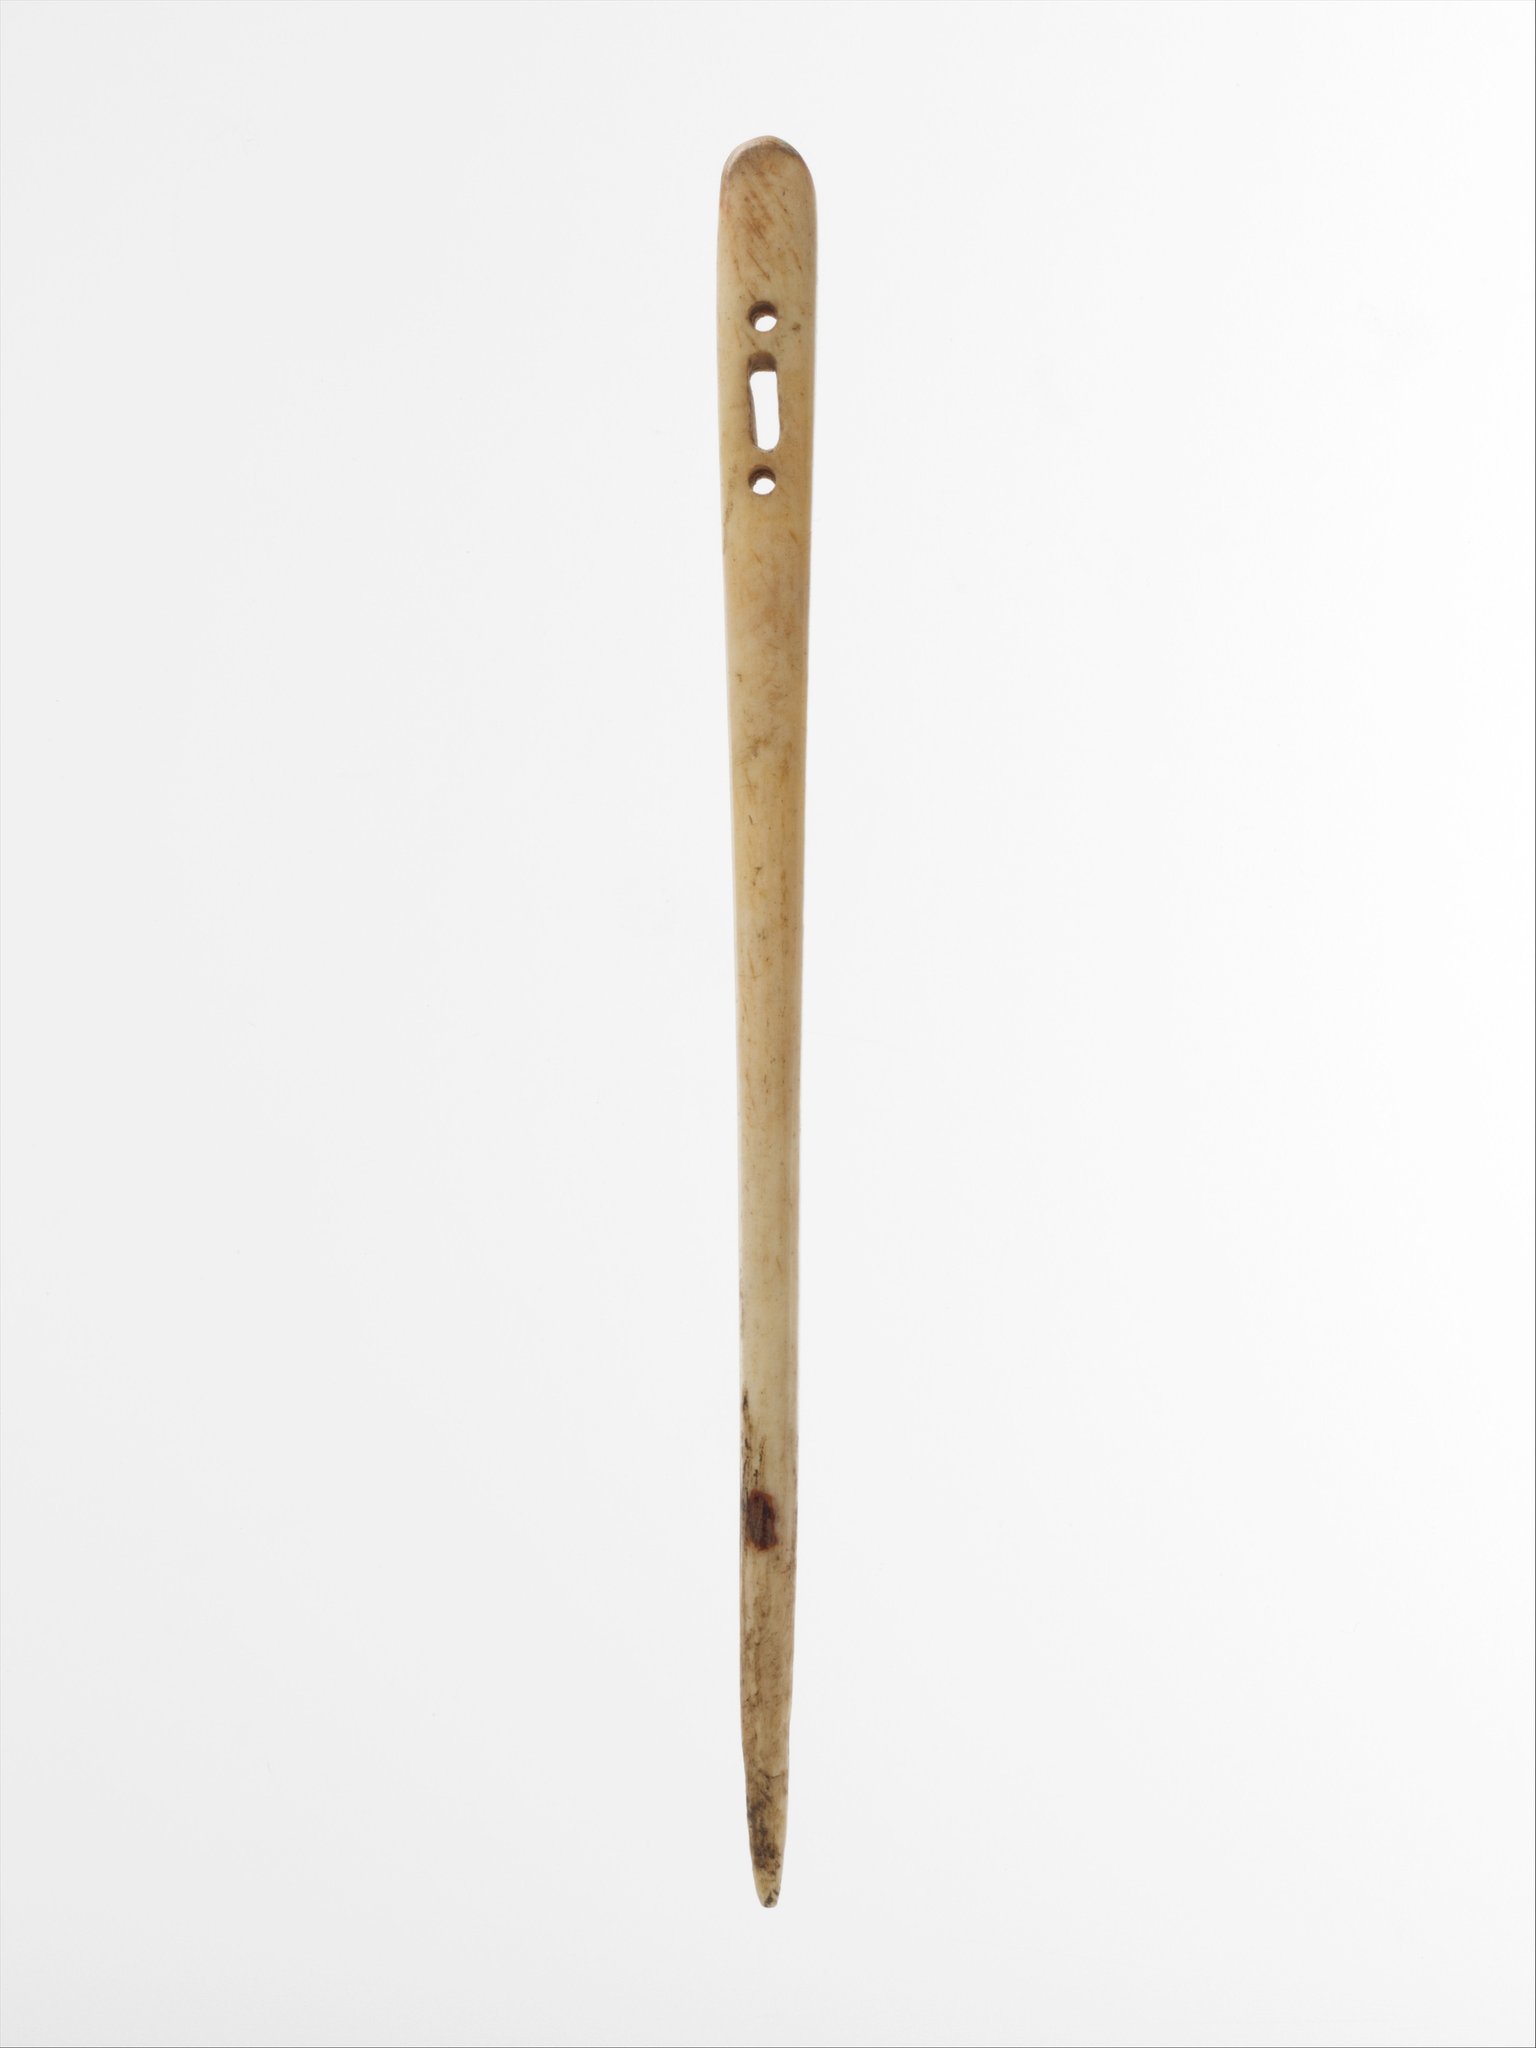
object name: needle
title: Bone needle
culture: roman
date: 101-500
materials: bone, ivory